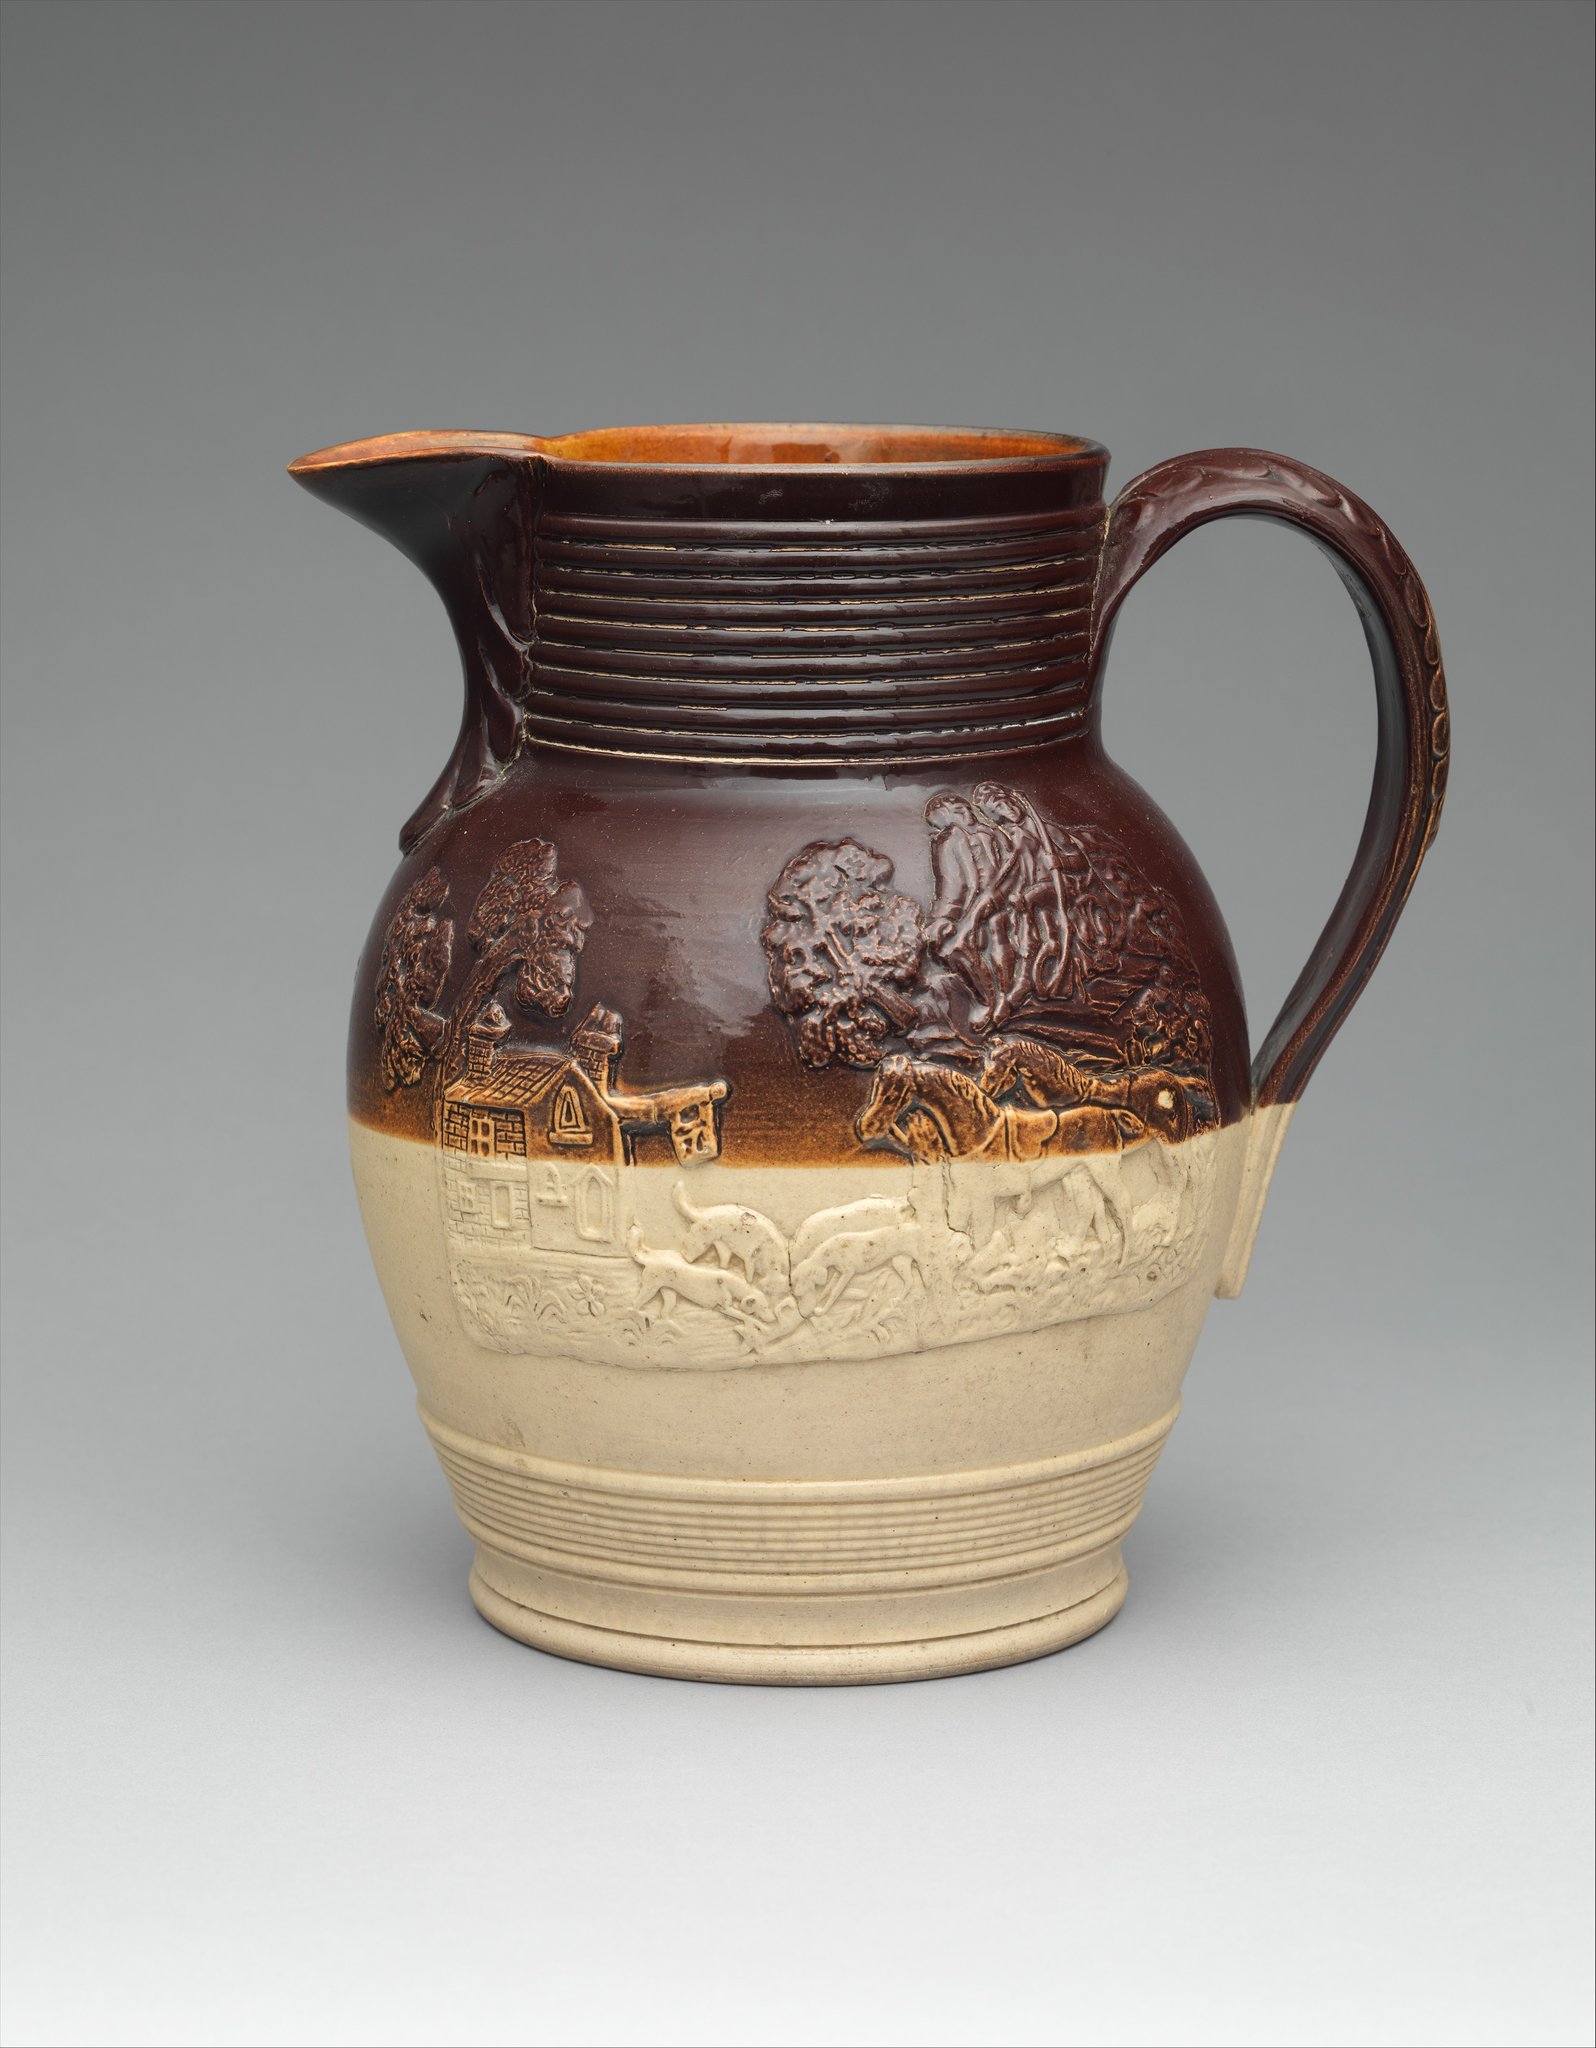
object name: pitcher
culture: american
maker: d. & j. henderson flint stoneware manufactory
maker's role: manufacturer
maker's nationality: american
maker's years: 1829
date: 1829-1833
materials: stoneware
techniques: casting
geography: united states